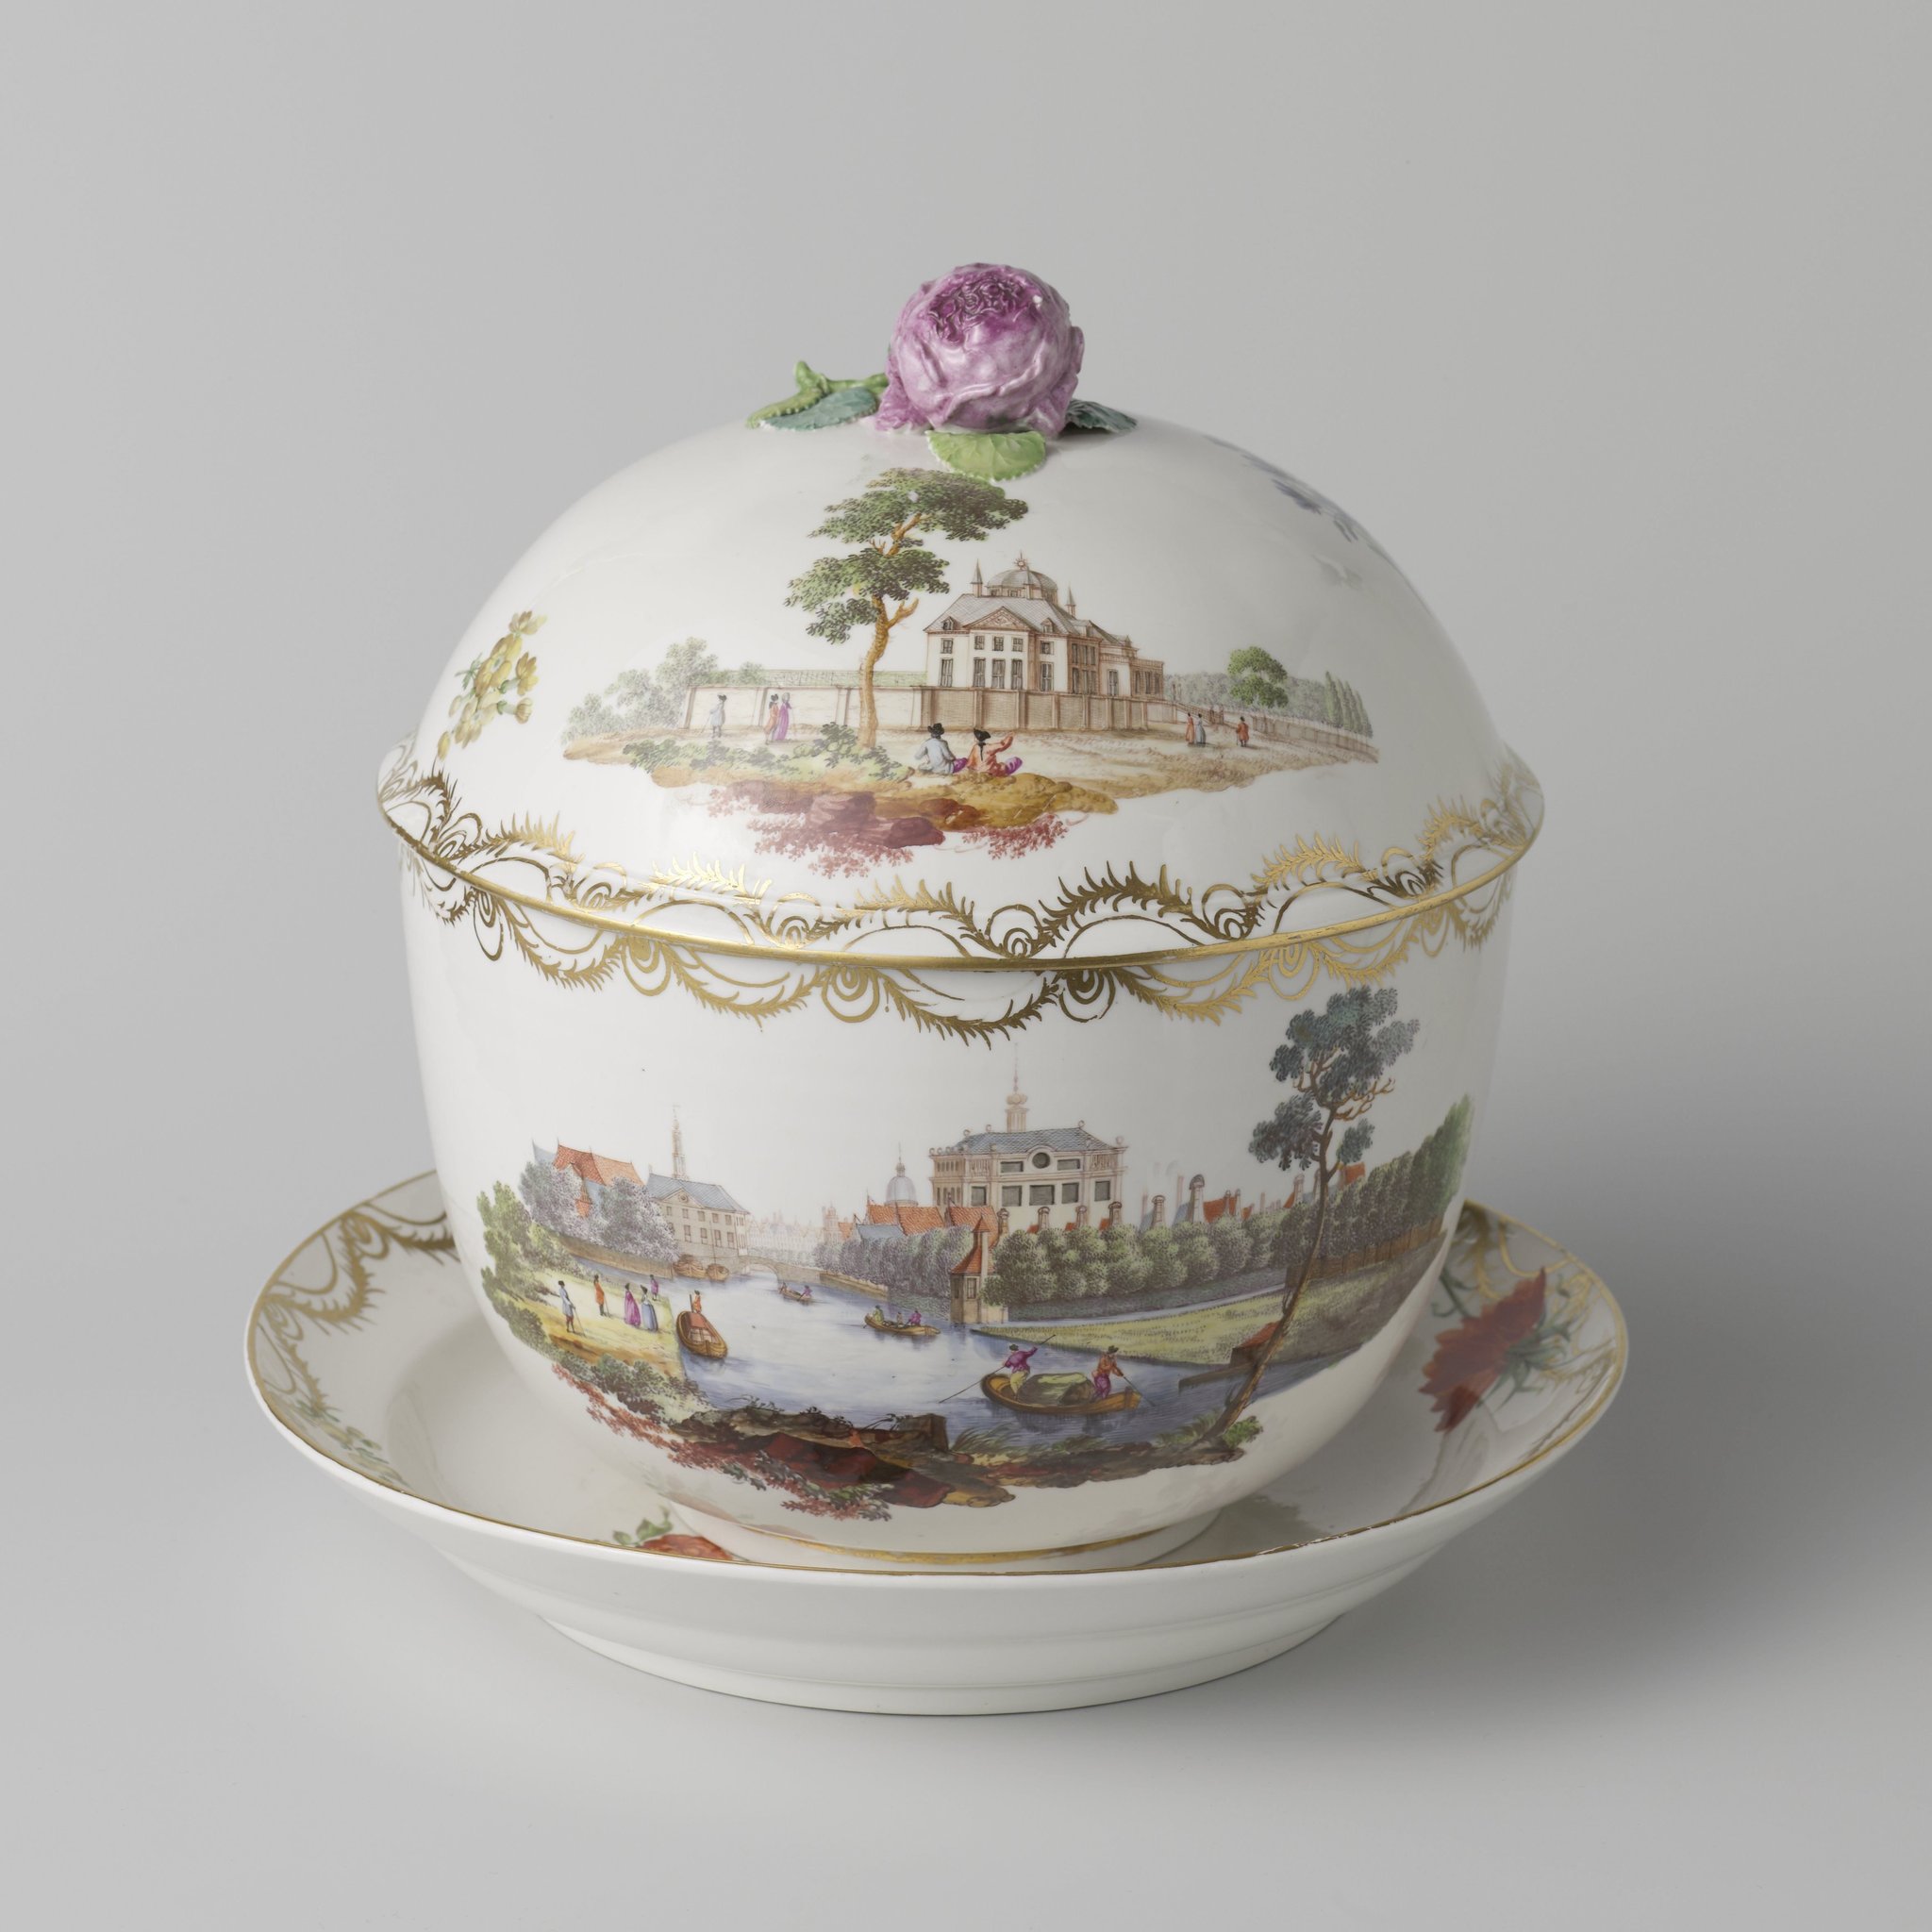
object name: lid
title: Deksel behorende bij punchkom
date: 1777-1790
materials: porcelain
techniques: painted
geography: the hague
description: Deksel behorende bij een punchkom met onderschotel. Vveelkleurig beschilderd aan twee kanten met aan één kant een gezicht op de Portugese Synagoge in Amsterdam en de andere kant een waterlandschap met zeilschepen. Op de deksel is het Huis ten Bosch afgebeeld. Als knop van de deksel een roos. Gemerkt met een ooievaar in blauw onder het glazuur.